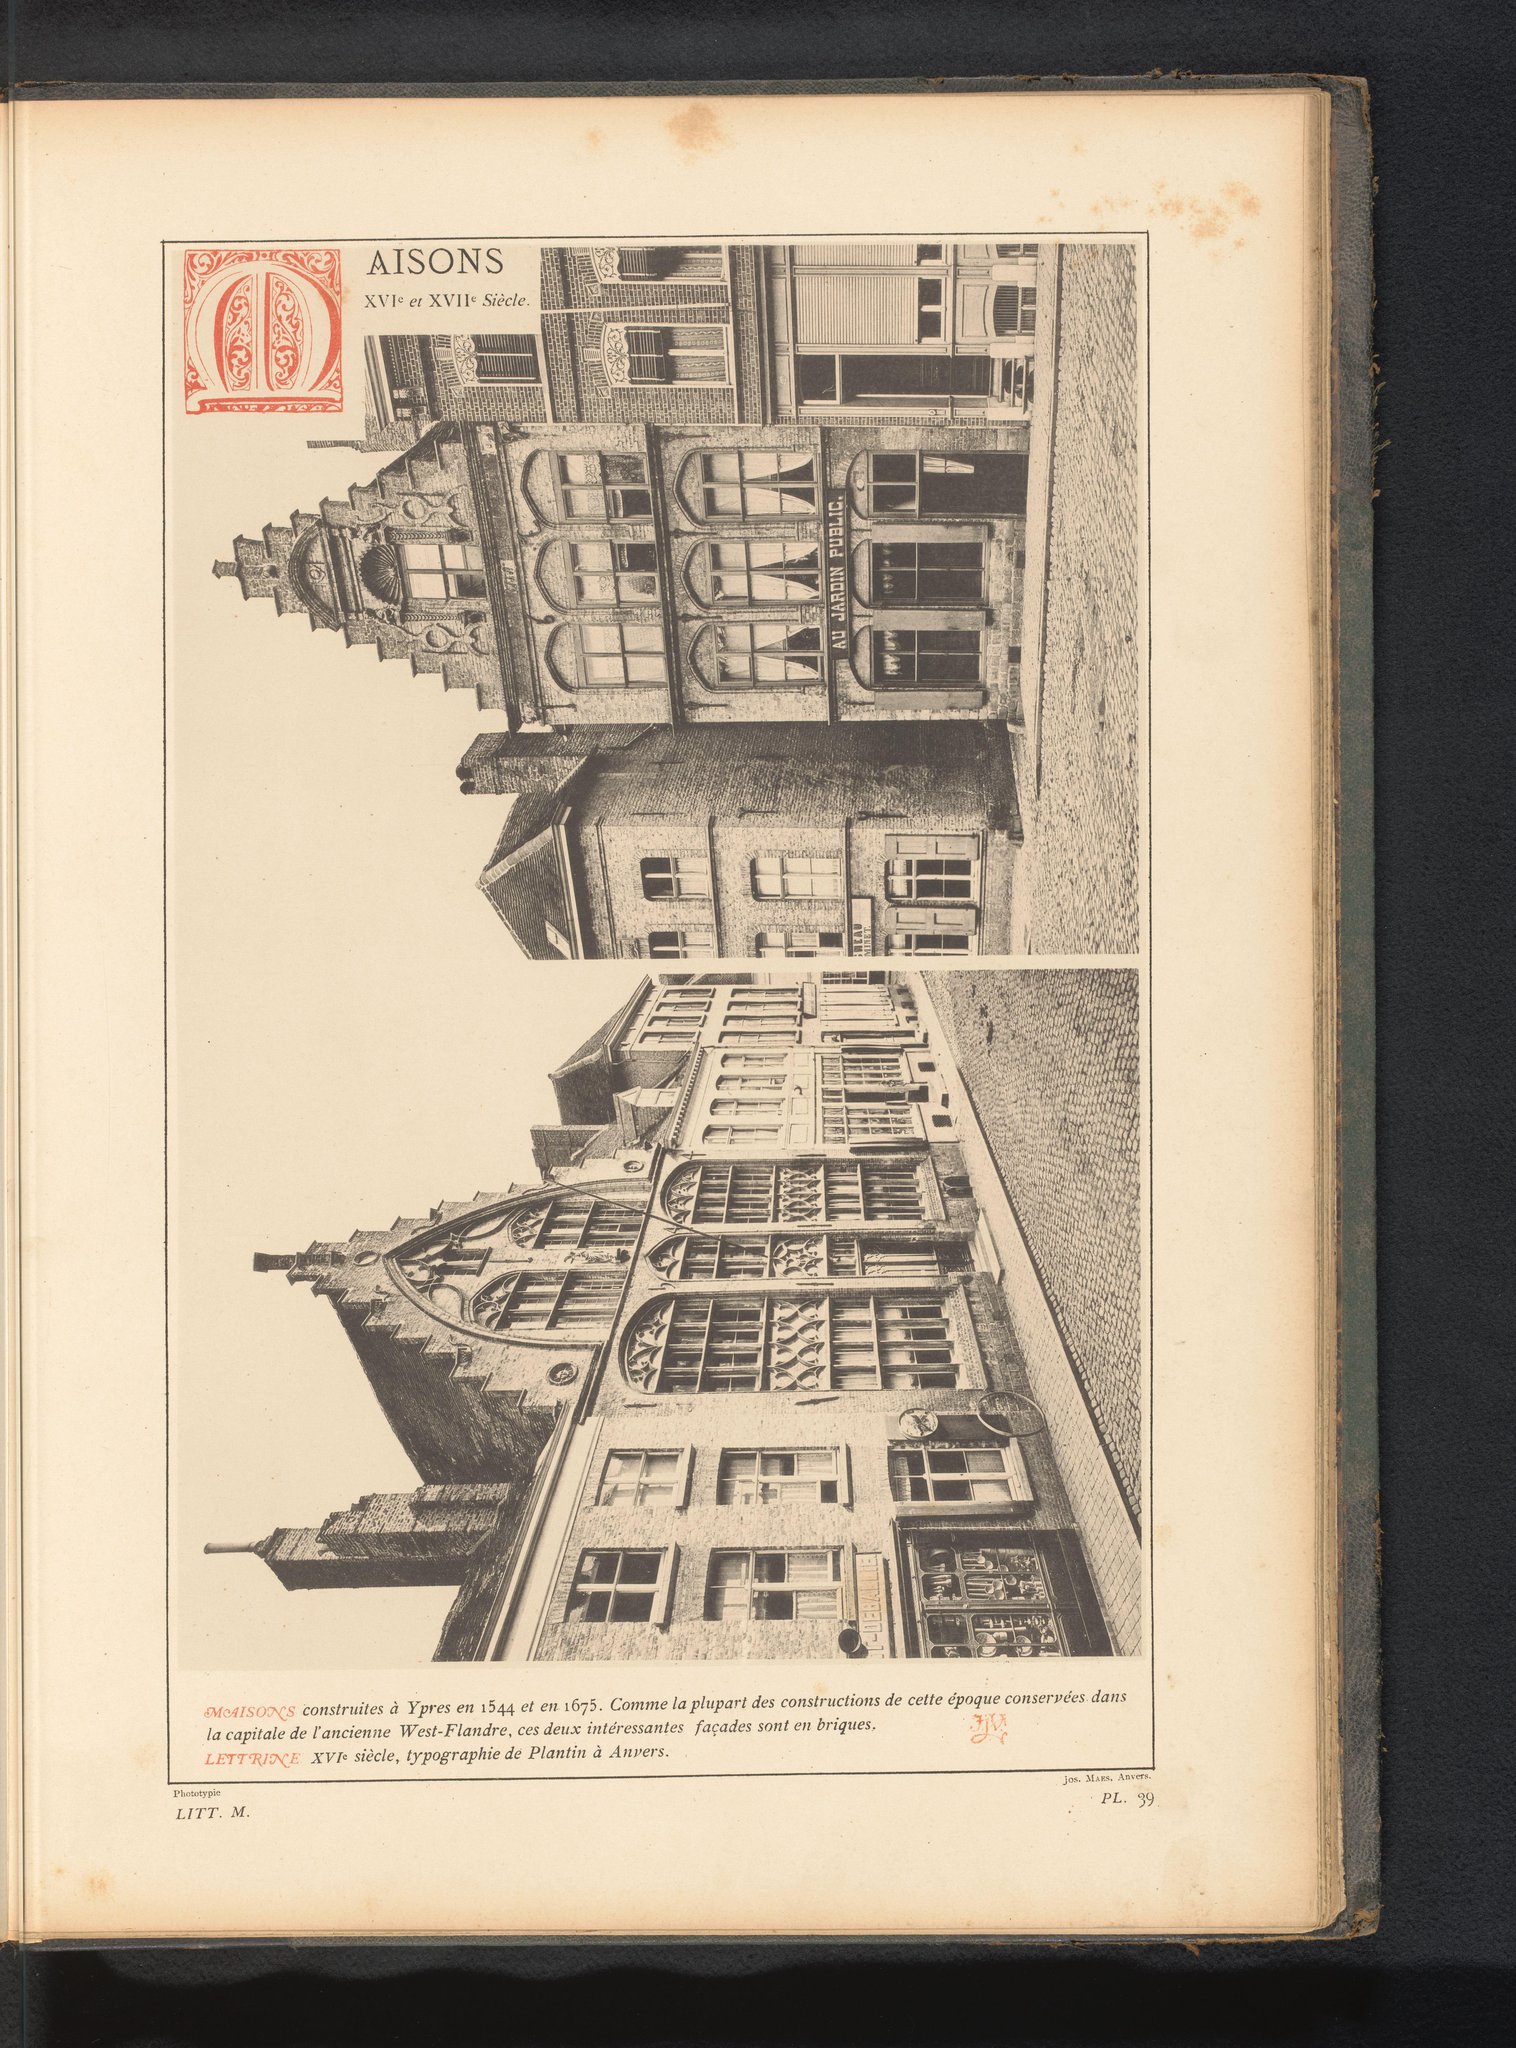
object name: photomechanical print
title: Maisons, XVIe et XVIIe Siècle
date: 1875-1880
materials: paper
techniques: photograph, photolithography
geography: antwerp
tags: the usual house or row of houses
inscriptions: monogram: ‘JJvY’, inscription: ‘MAISONS construites à (...)’, inscription: ‘LITT. M. - PL. 39’